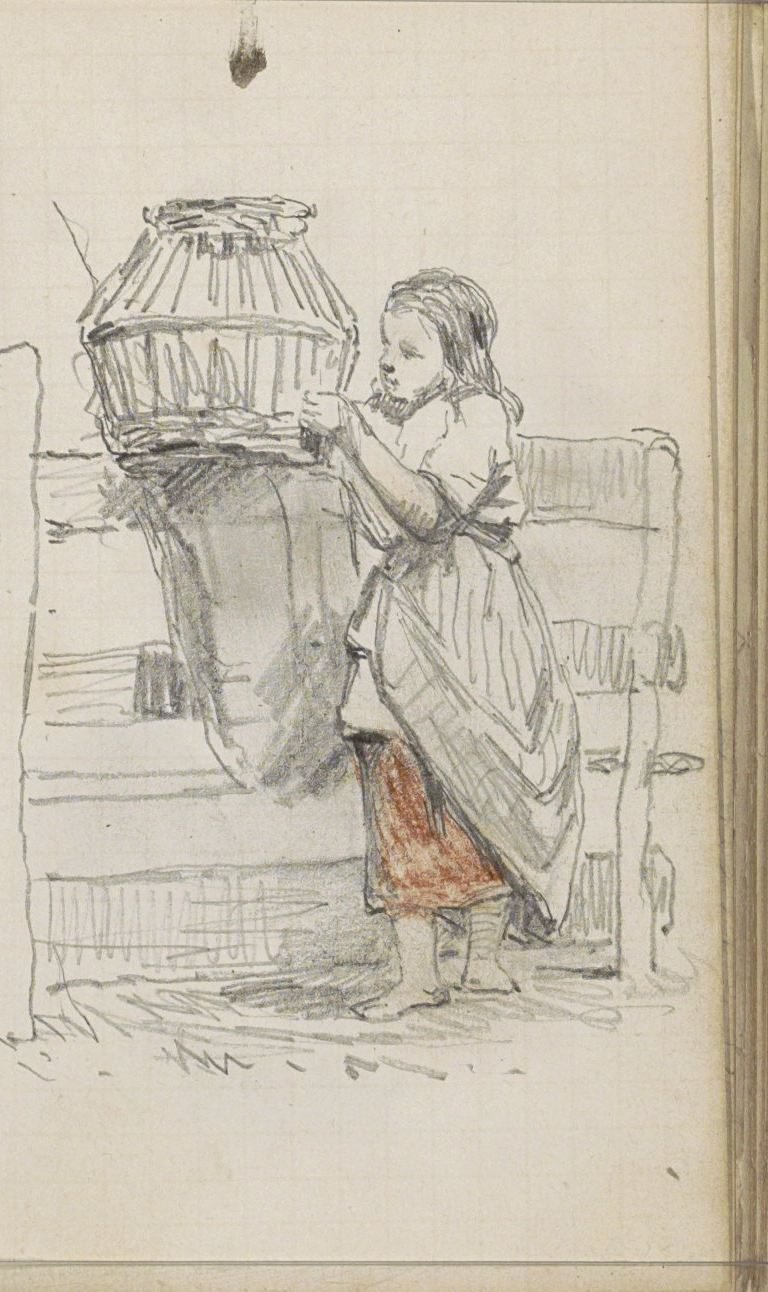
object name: sketchbook leaf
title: Meisje met een kooi naast een hek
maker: jan willem van borselen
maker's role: draughtsman, print maker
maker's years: 1825-1892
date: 1868-1887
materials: chalk, pencil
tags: fence, wall, paling, girl (child between toddler and youth)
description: Blad 14 recto uit een schetsboek met 51 bladen.